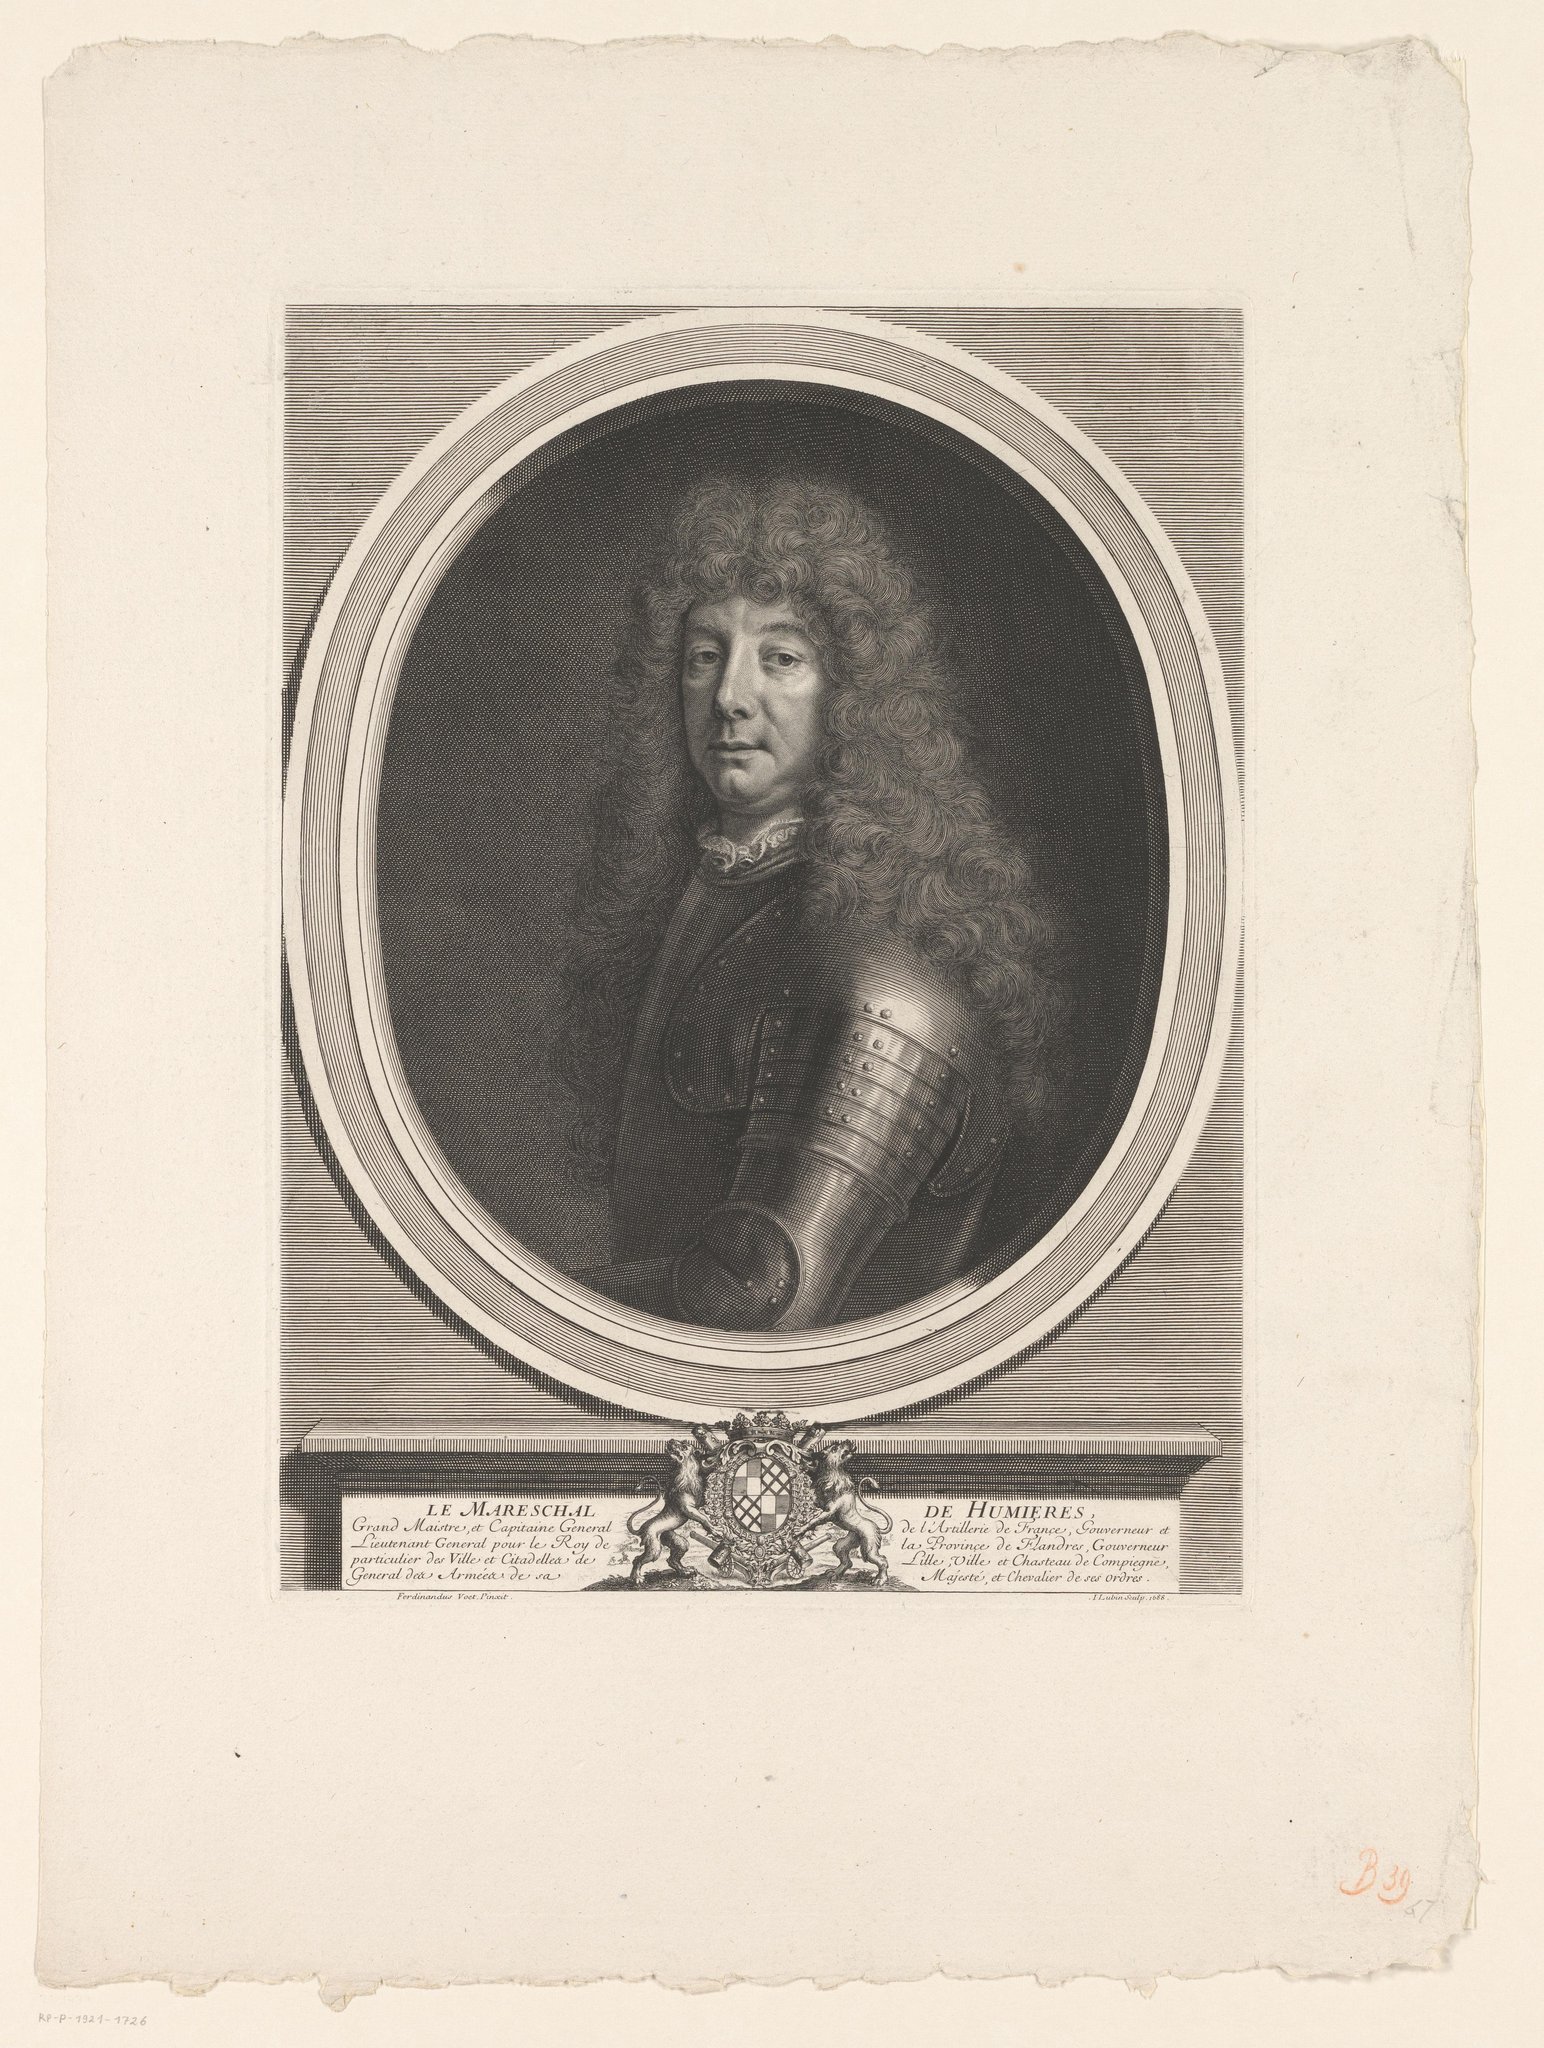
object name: print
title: Portret van Louis de Crevant, hertog van Humières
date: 1688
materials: paper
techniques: engraving, etching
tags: louis de crévant (hertog van humières), historical persons, armorial bearing, heraldry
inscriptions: collector's mark: Lugt 2233